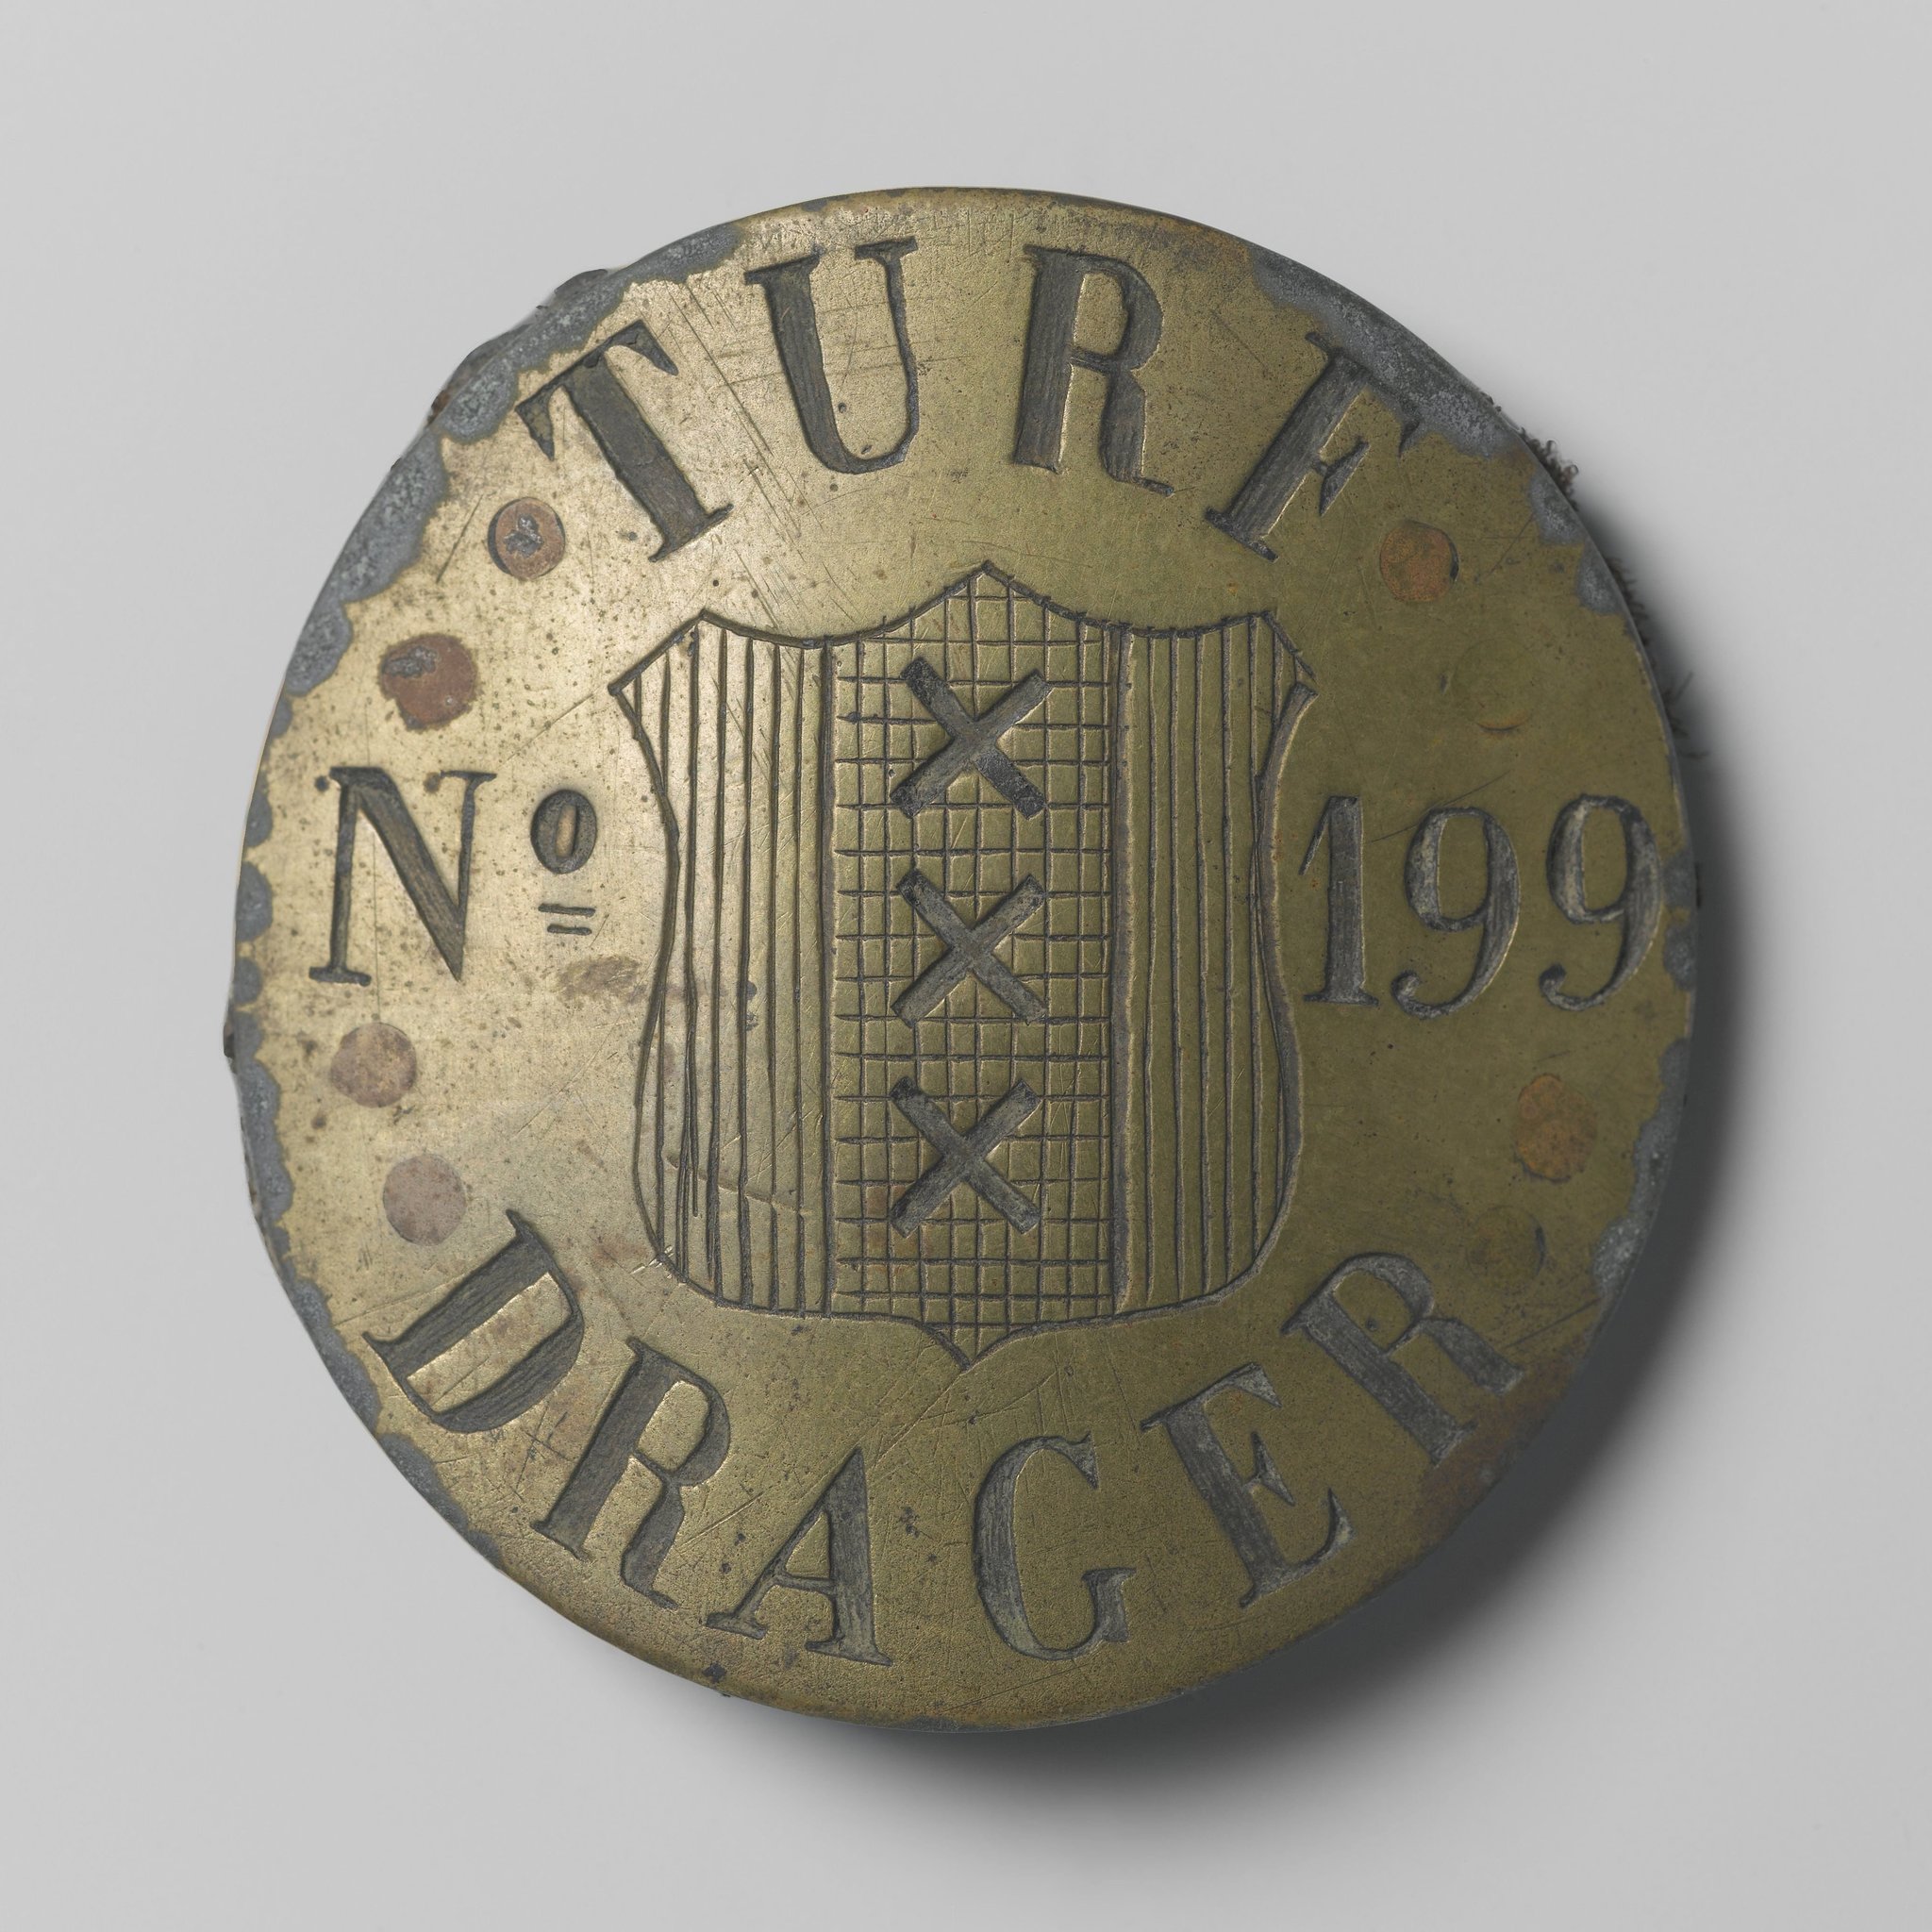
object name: plaque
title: Turfdragers van Amsterdam, plaquette met no. 199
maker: Anonymous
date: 1750-1850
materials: brass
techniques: engraving, nailed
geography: amsterdam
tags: amsterdam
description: Bolle, eenzijdige messing penning, waarop aan keerzijde met vier nagels een stuk textiel, afgedekt met een metalen plaatje is gezet. Voorzijde: wapenschild tussen opschrift No 199 binnen omschrift. Keerzijde: blanco.